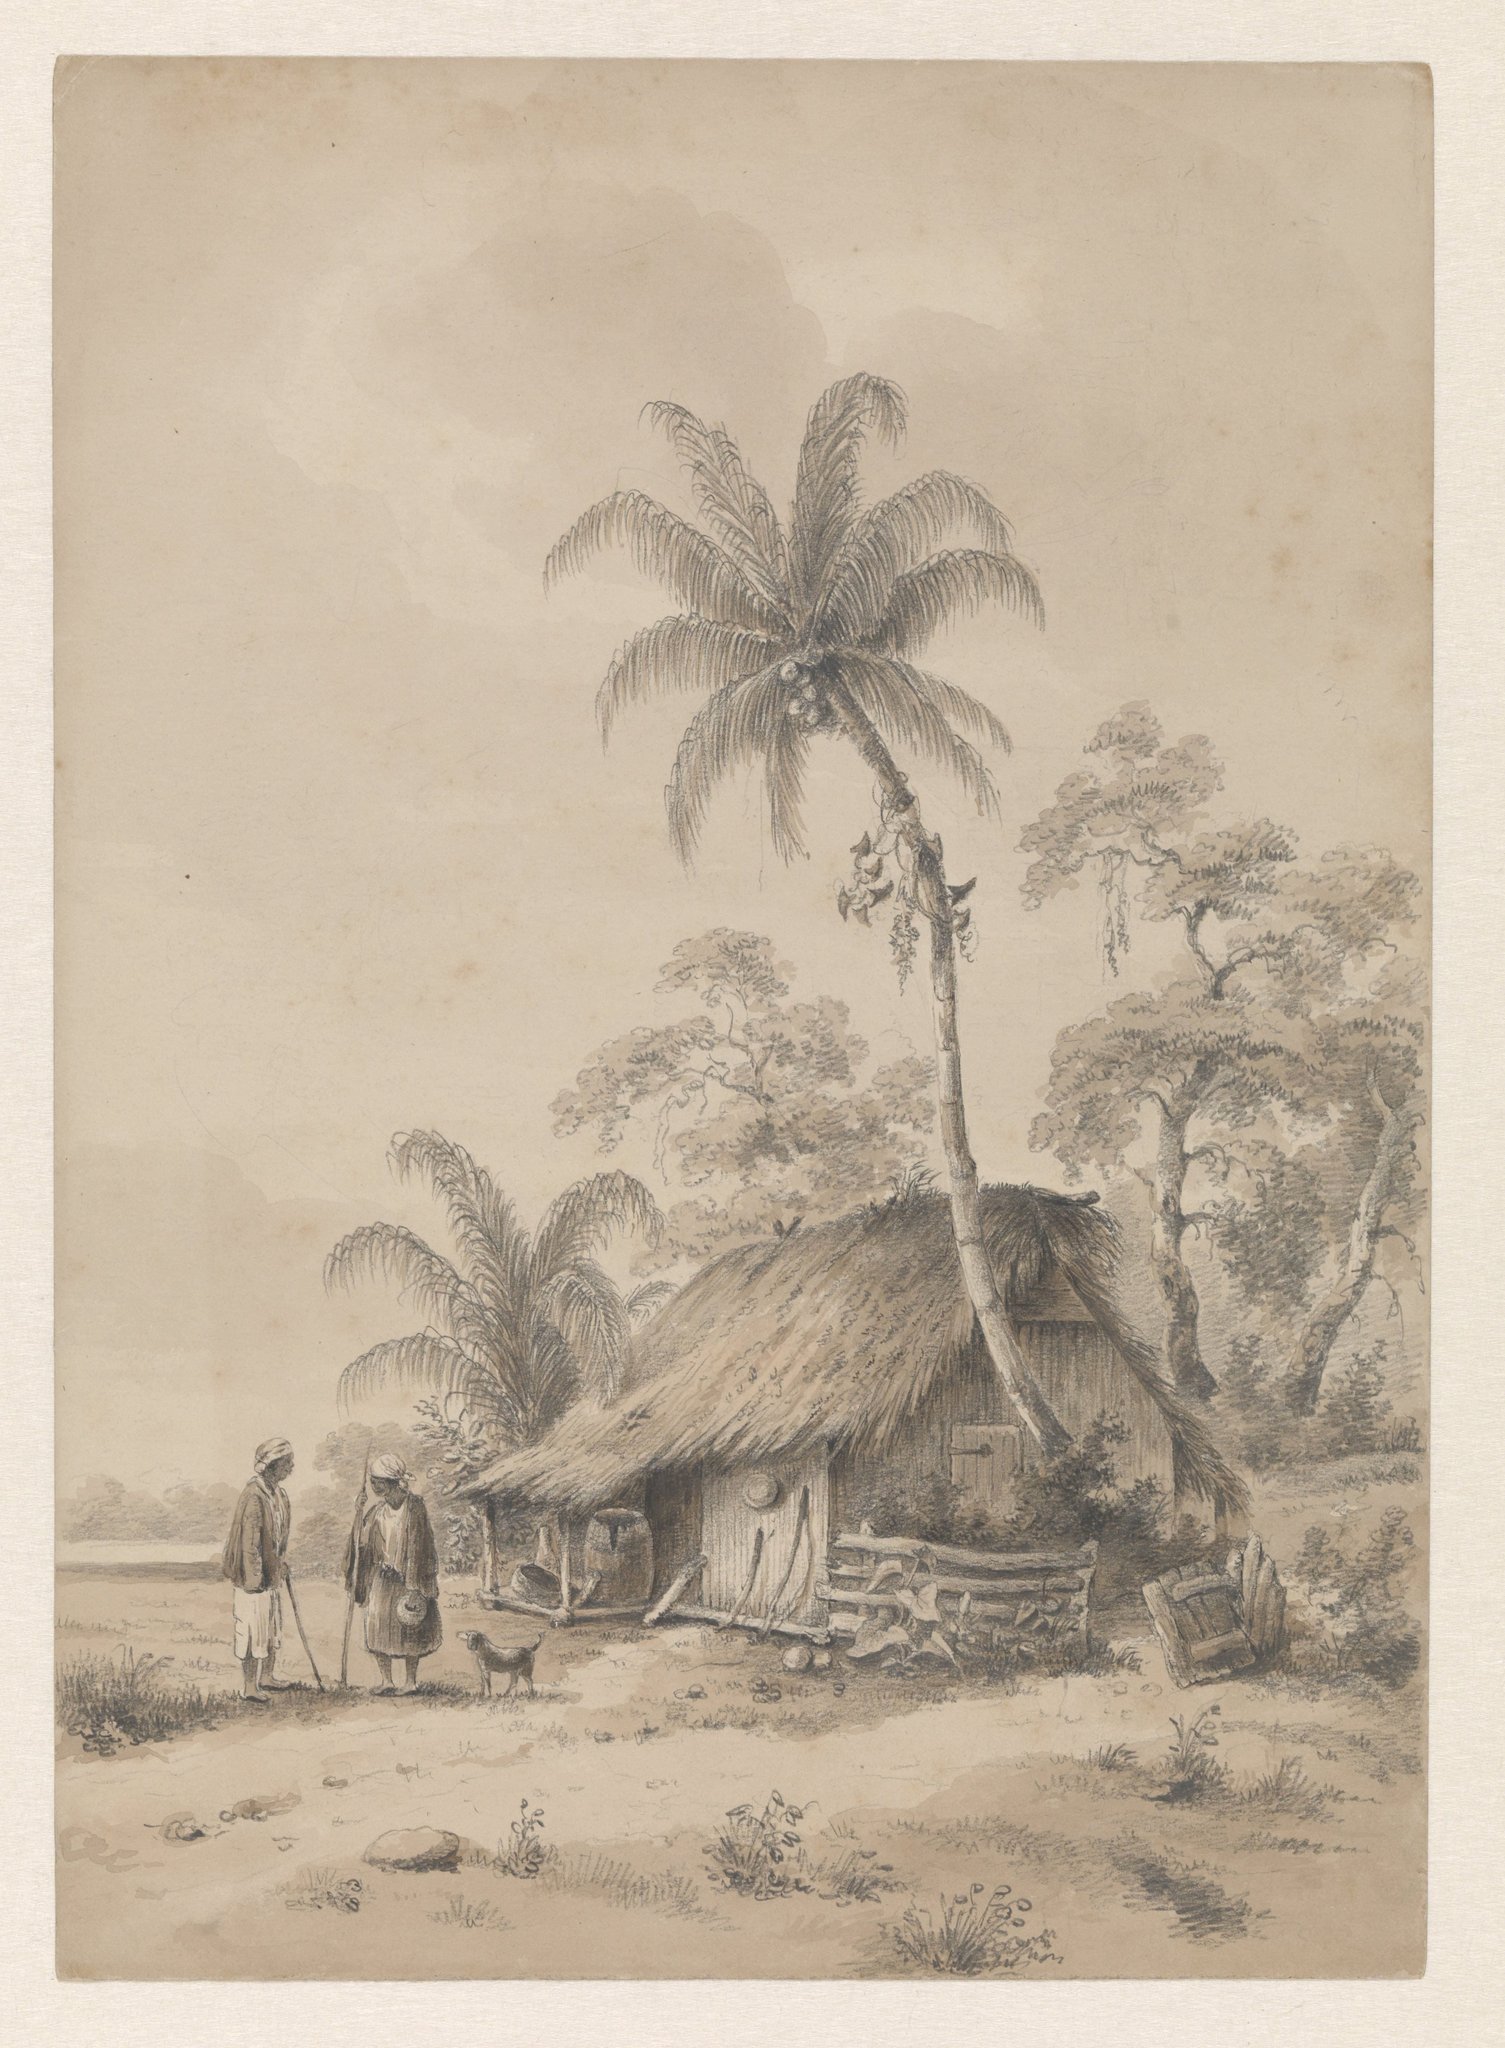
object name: drawing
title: Hut met twee personen en een hond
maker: hendrik huygens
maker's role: amateurtekenaar, officier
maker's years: 1810-1867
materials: paper, pencil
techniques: brush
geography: paramaribo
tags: landscapes in tropical and sub-tropical regions, suriname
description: Een houten hut met een dak van bladeren en links twee personen en een hond.